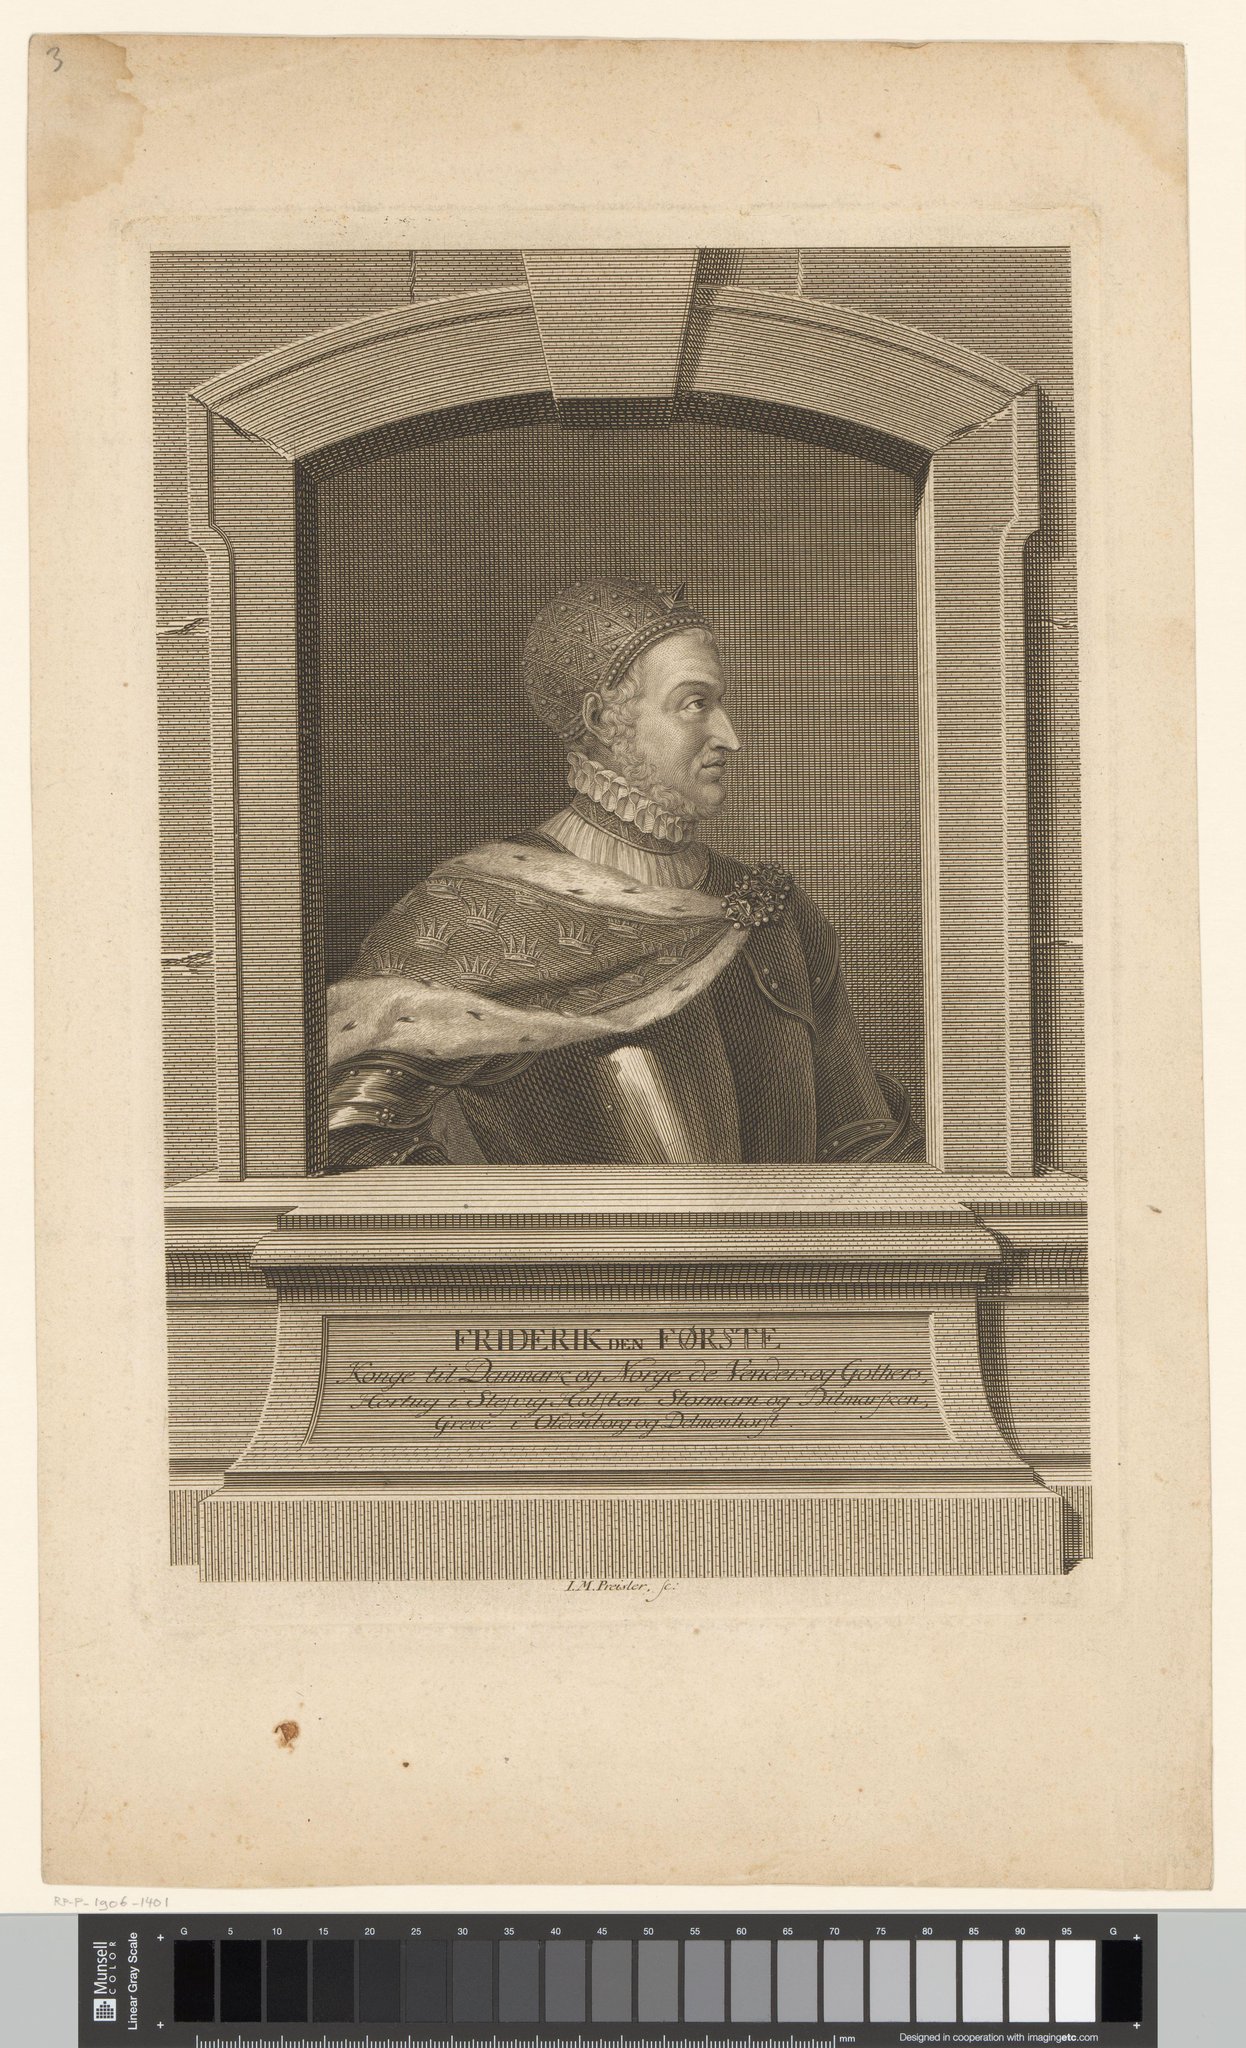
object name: print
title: Portret van Frederik I, koning van Denemarken en Noorwegen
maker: johann martin preissler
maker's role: print maker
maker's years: 1715-1794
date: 1725-1794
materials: paper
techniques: engraving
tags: historical persons - bb - woman, armour, insignia and symbols of sovereignty (crown, diadem, sceptre, orb, seal, standard, cloak, pectoral)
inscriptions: collector's mark: Lugt 2228